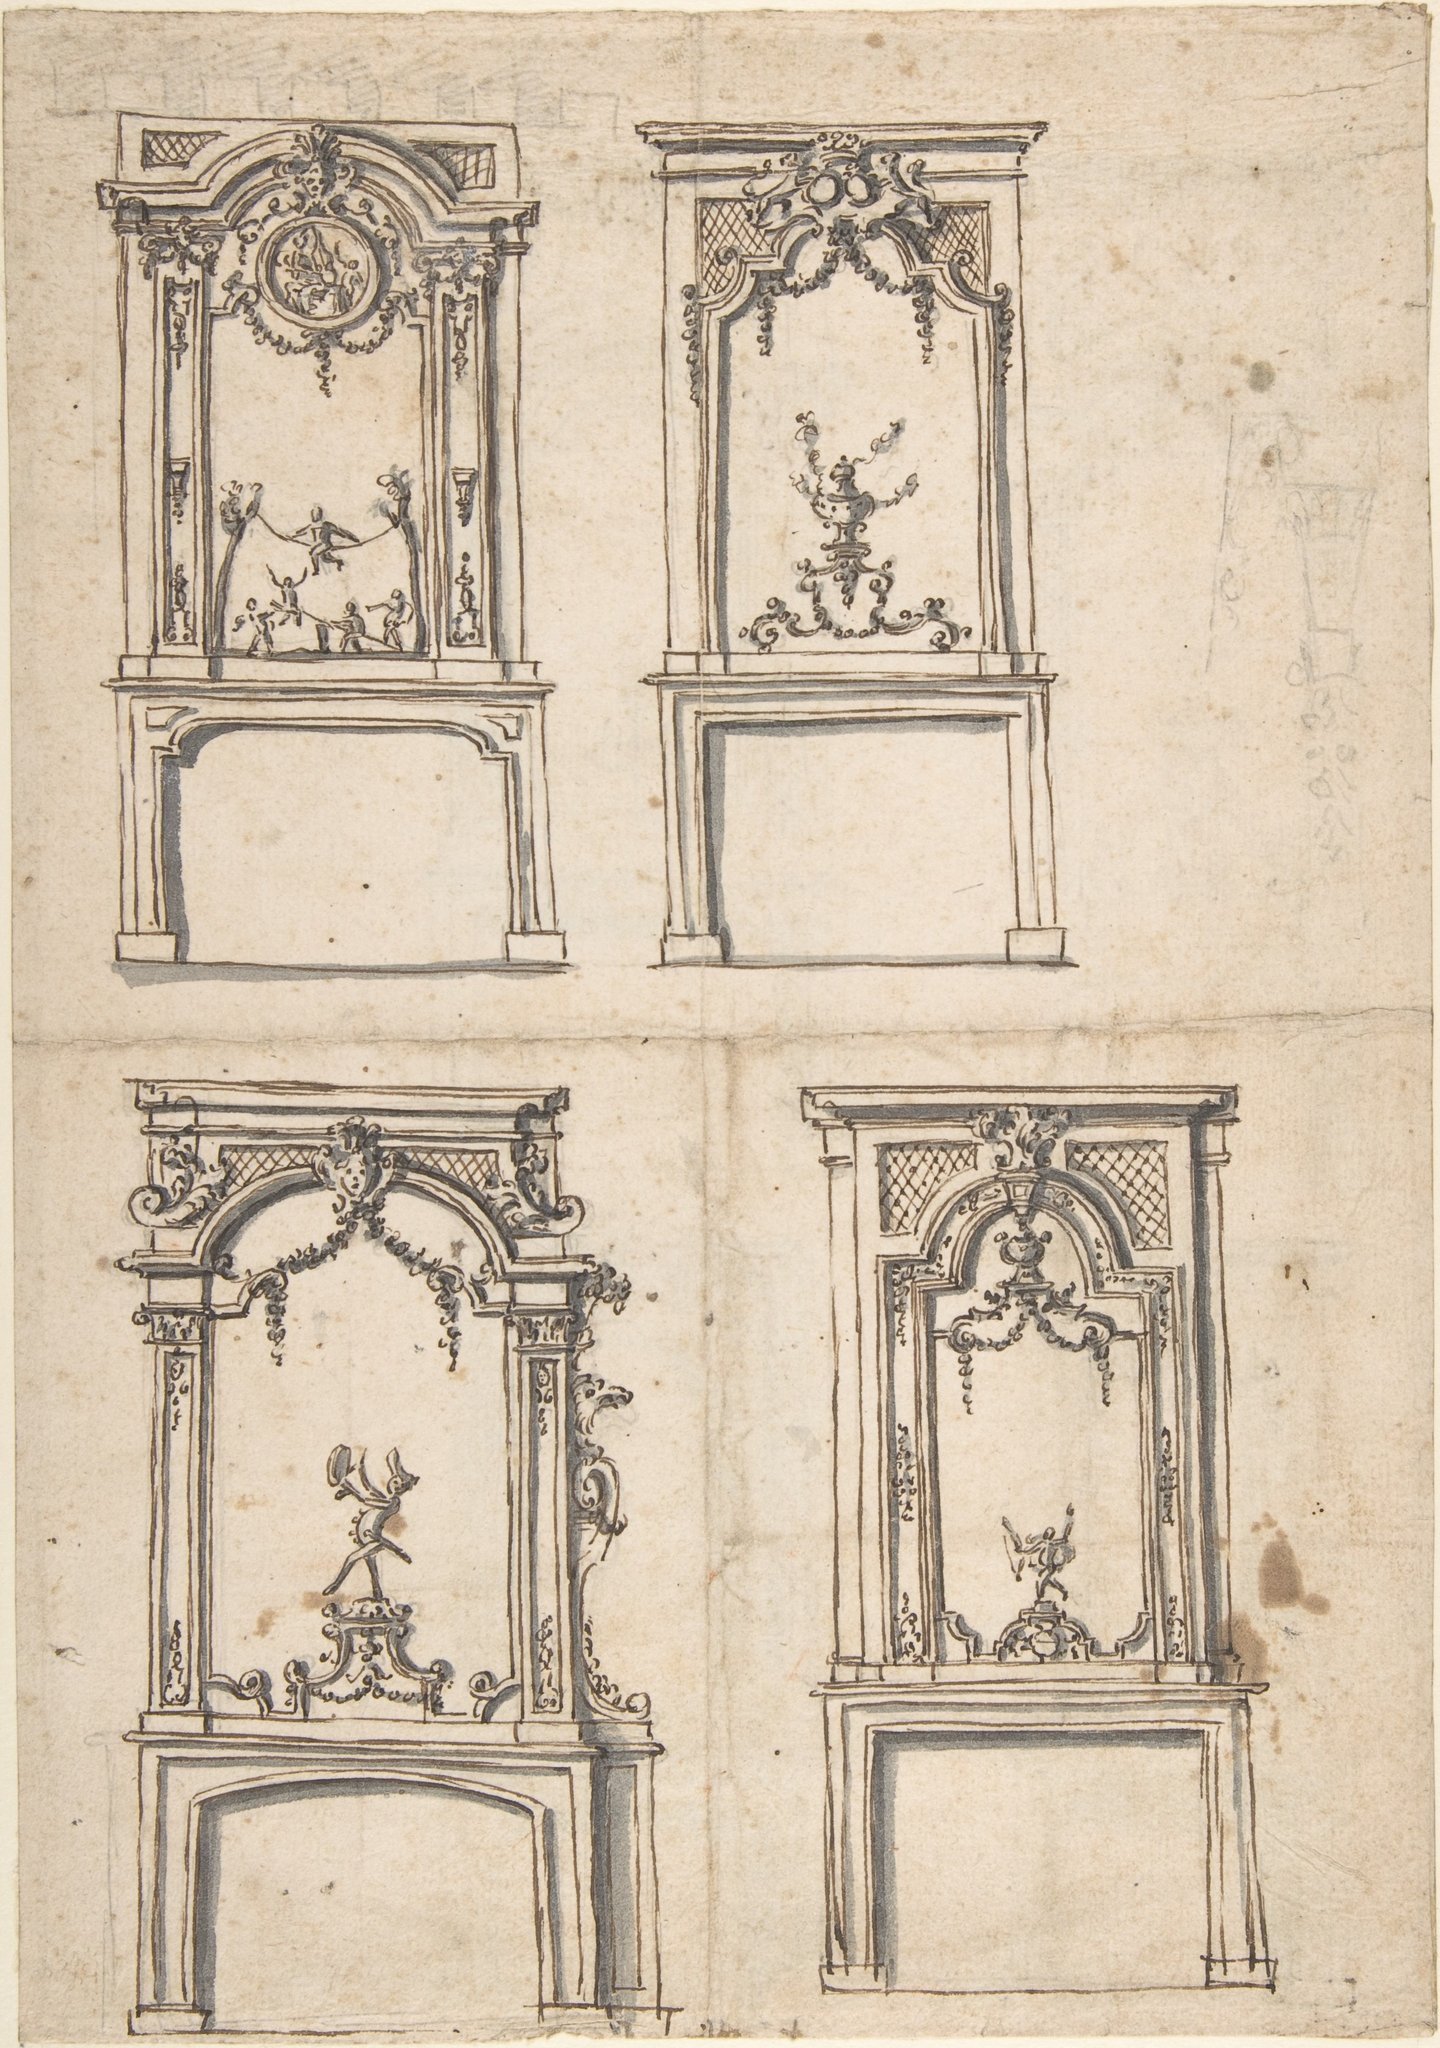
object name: drawing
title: Designs for Overmantles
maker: anonymous, french, 18th century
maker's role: artist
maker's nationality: french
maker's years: 1700-1800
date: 1701-1800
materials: graphite, ink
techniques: brush, pen, wash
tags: architecture